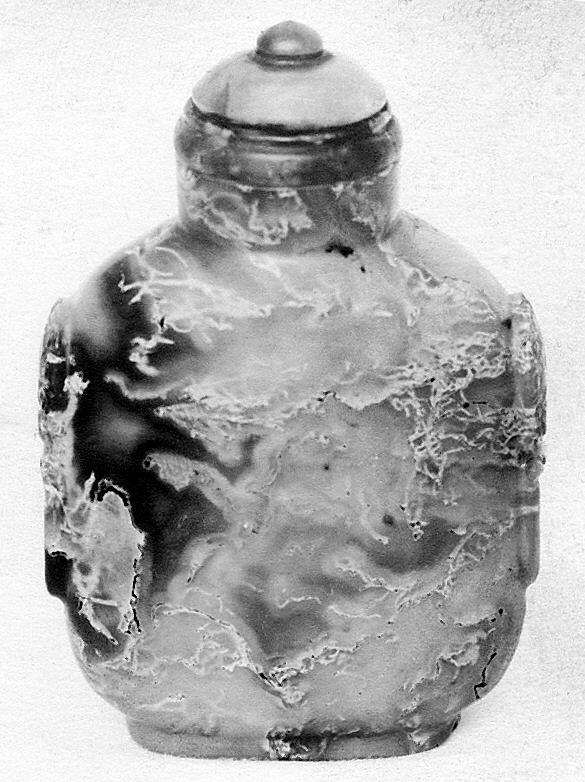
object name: snuff bottle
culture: chinese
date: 1801-1900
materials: stone, jade, quartz